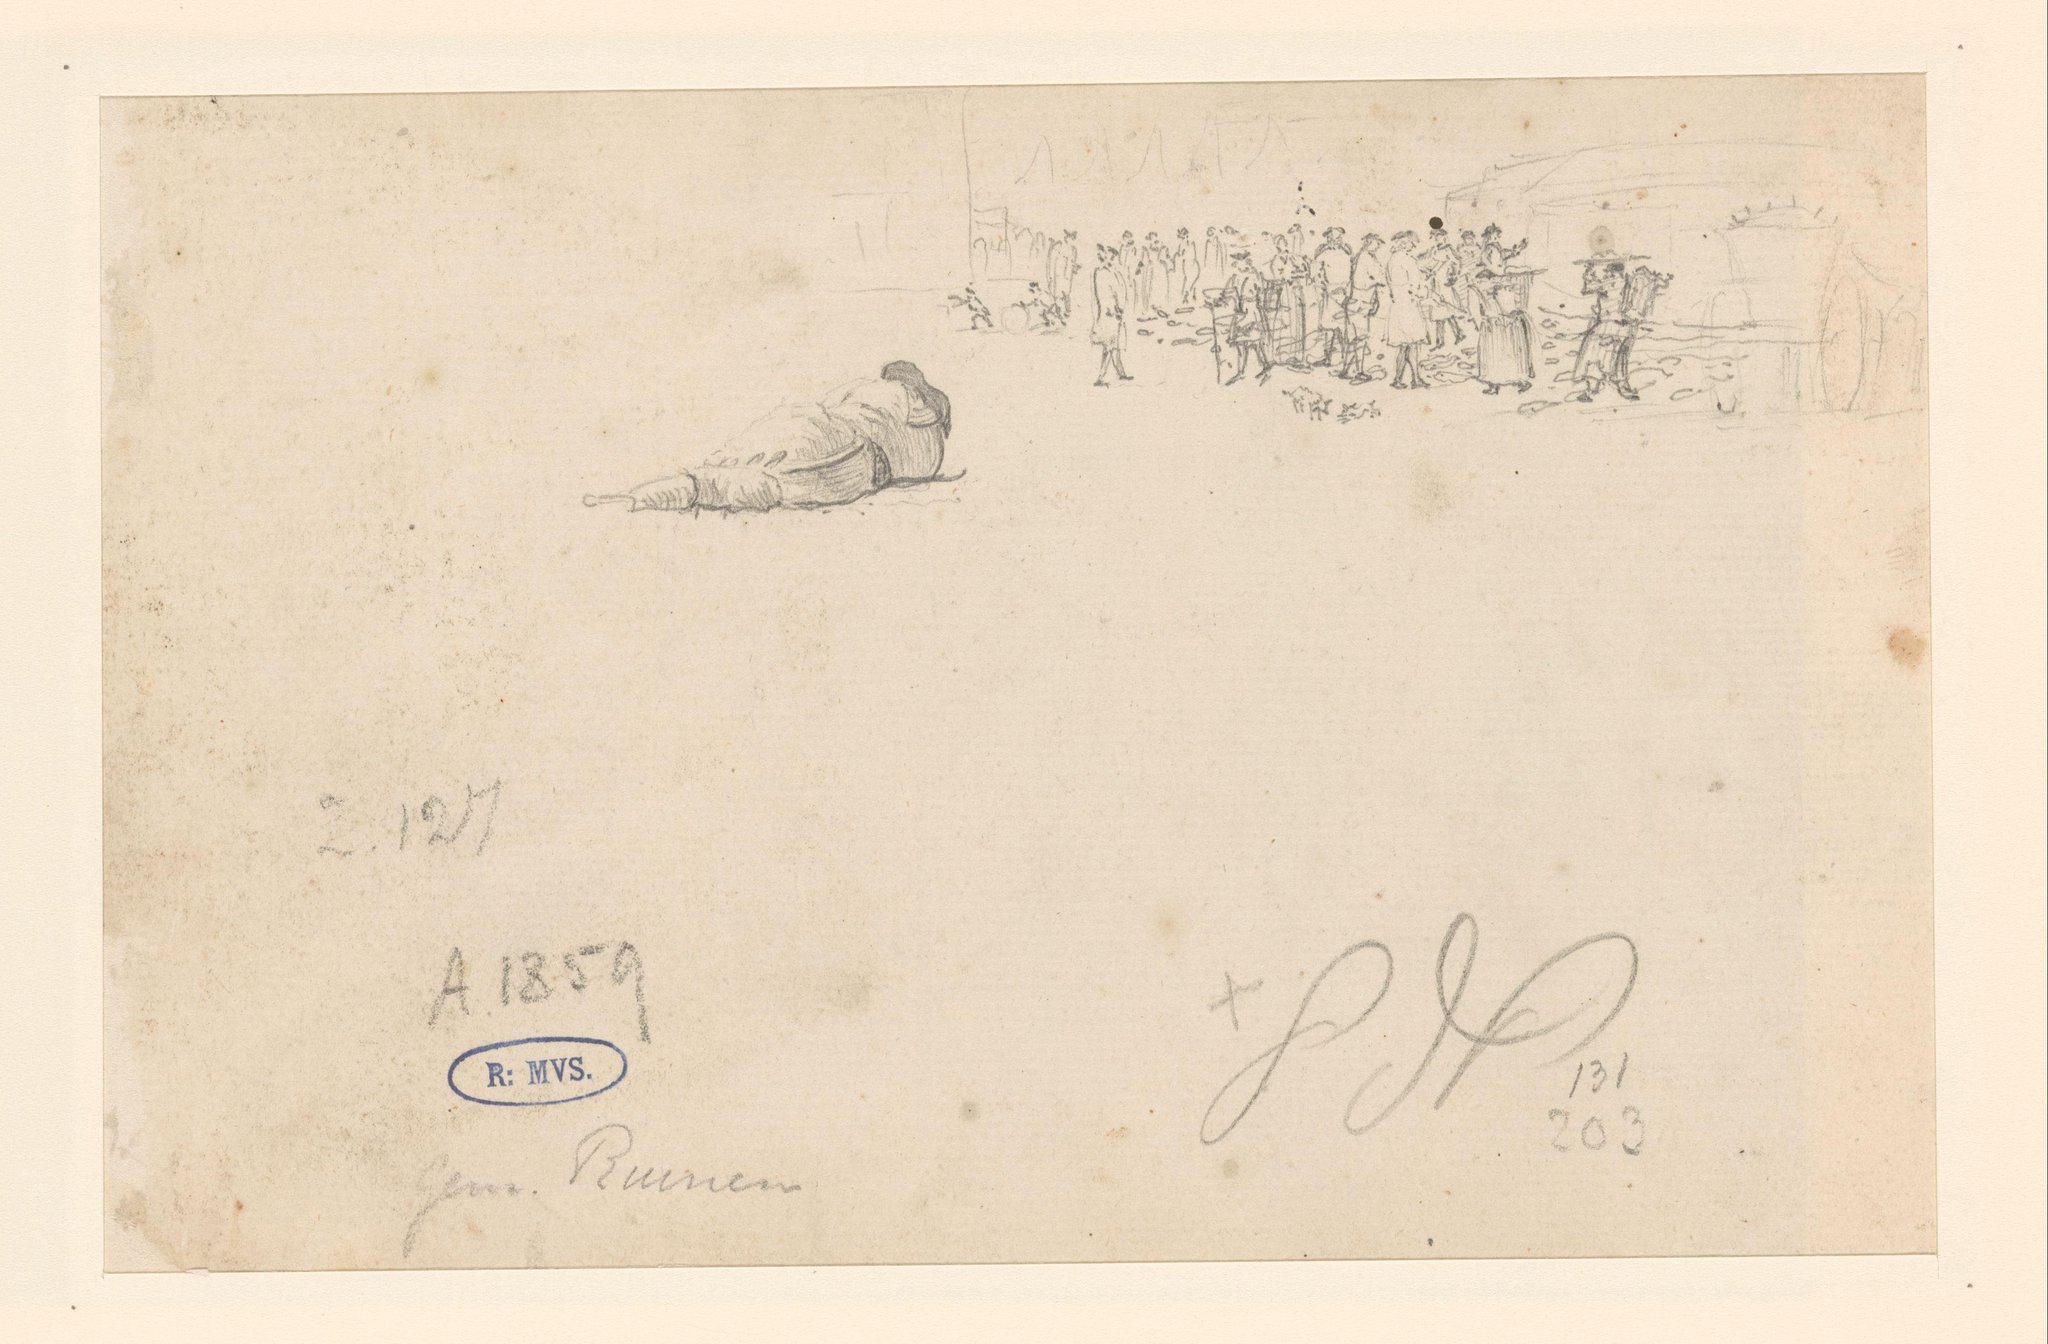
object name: drawing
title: Liggende figuur en een groep mensen bij een koets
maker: Anonymous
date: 1743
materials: paper, pencil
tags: lying figure, passenger carriage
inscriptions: collector's mark: Lugt 2228